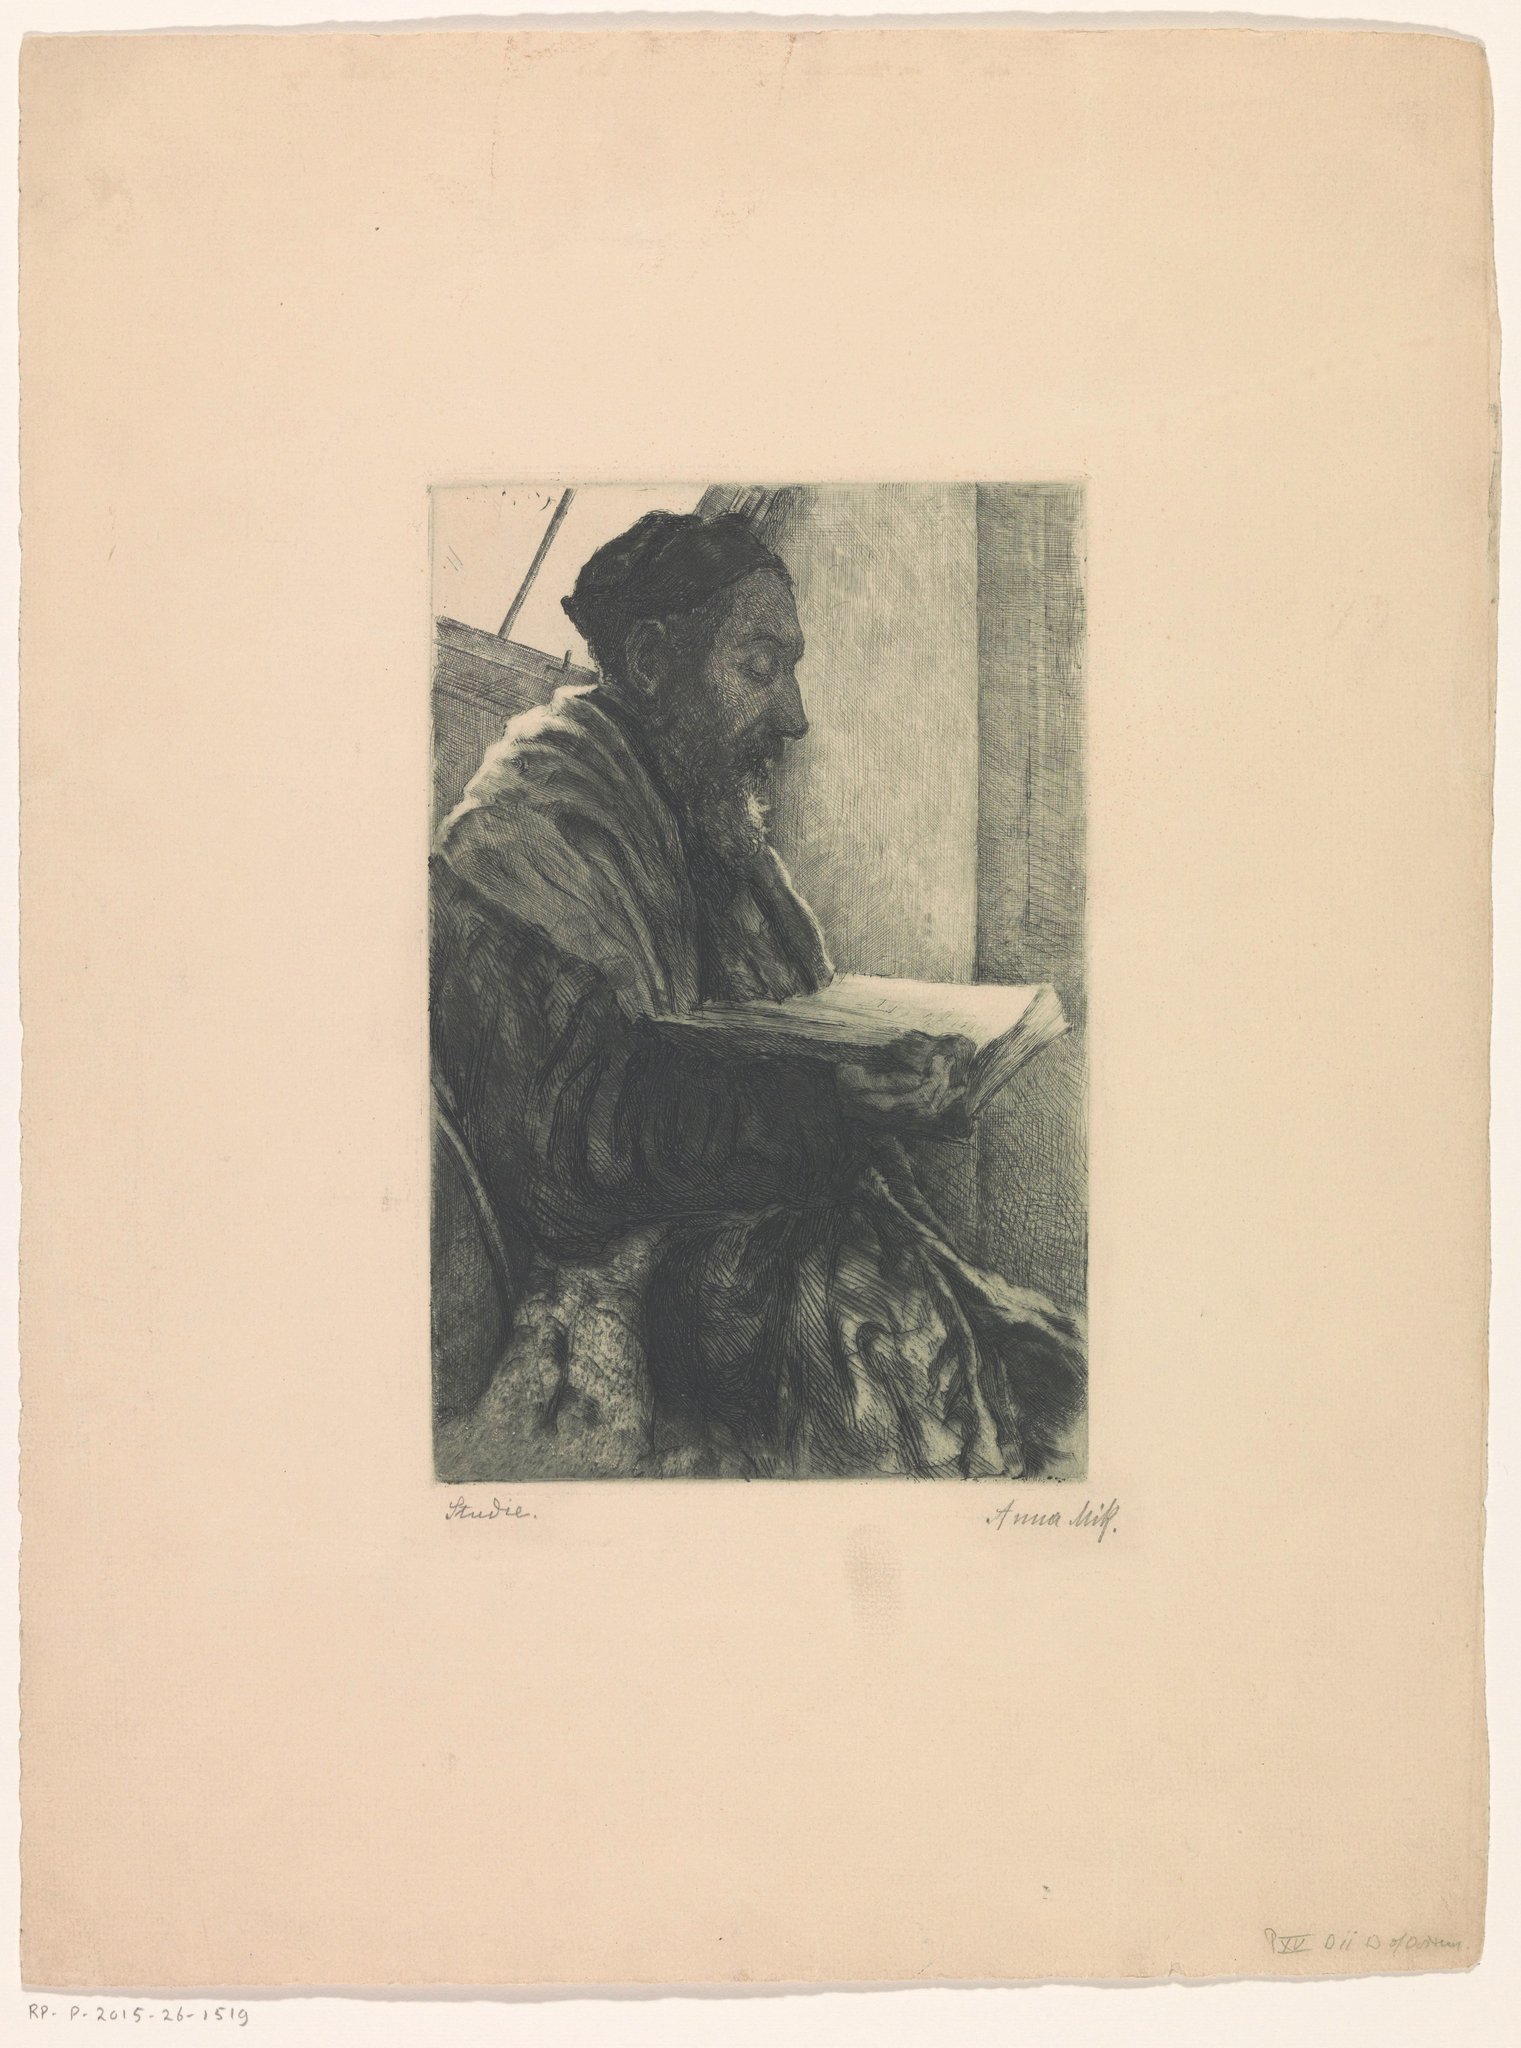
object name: print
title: Studie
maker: anna mik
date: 1900-1925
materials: paper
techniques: etching, intaglio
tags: reading, book, jewish religion and culture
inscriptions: collector's mark: Lugt 4779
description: Portret van een lezende jood met in zijn handen een opengeslagen boek. Om zijn schouders ligt een gebedssjaal.